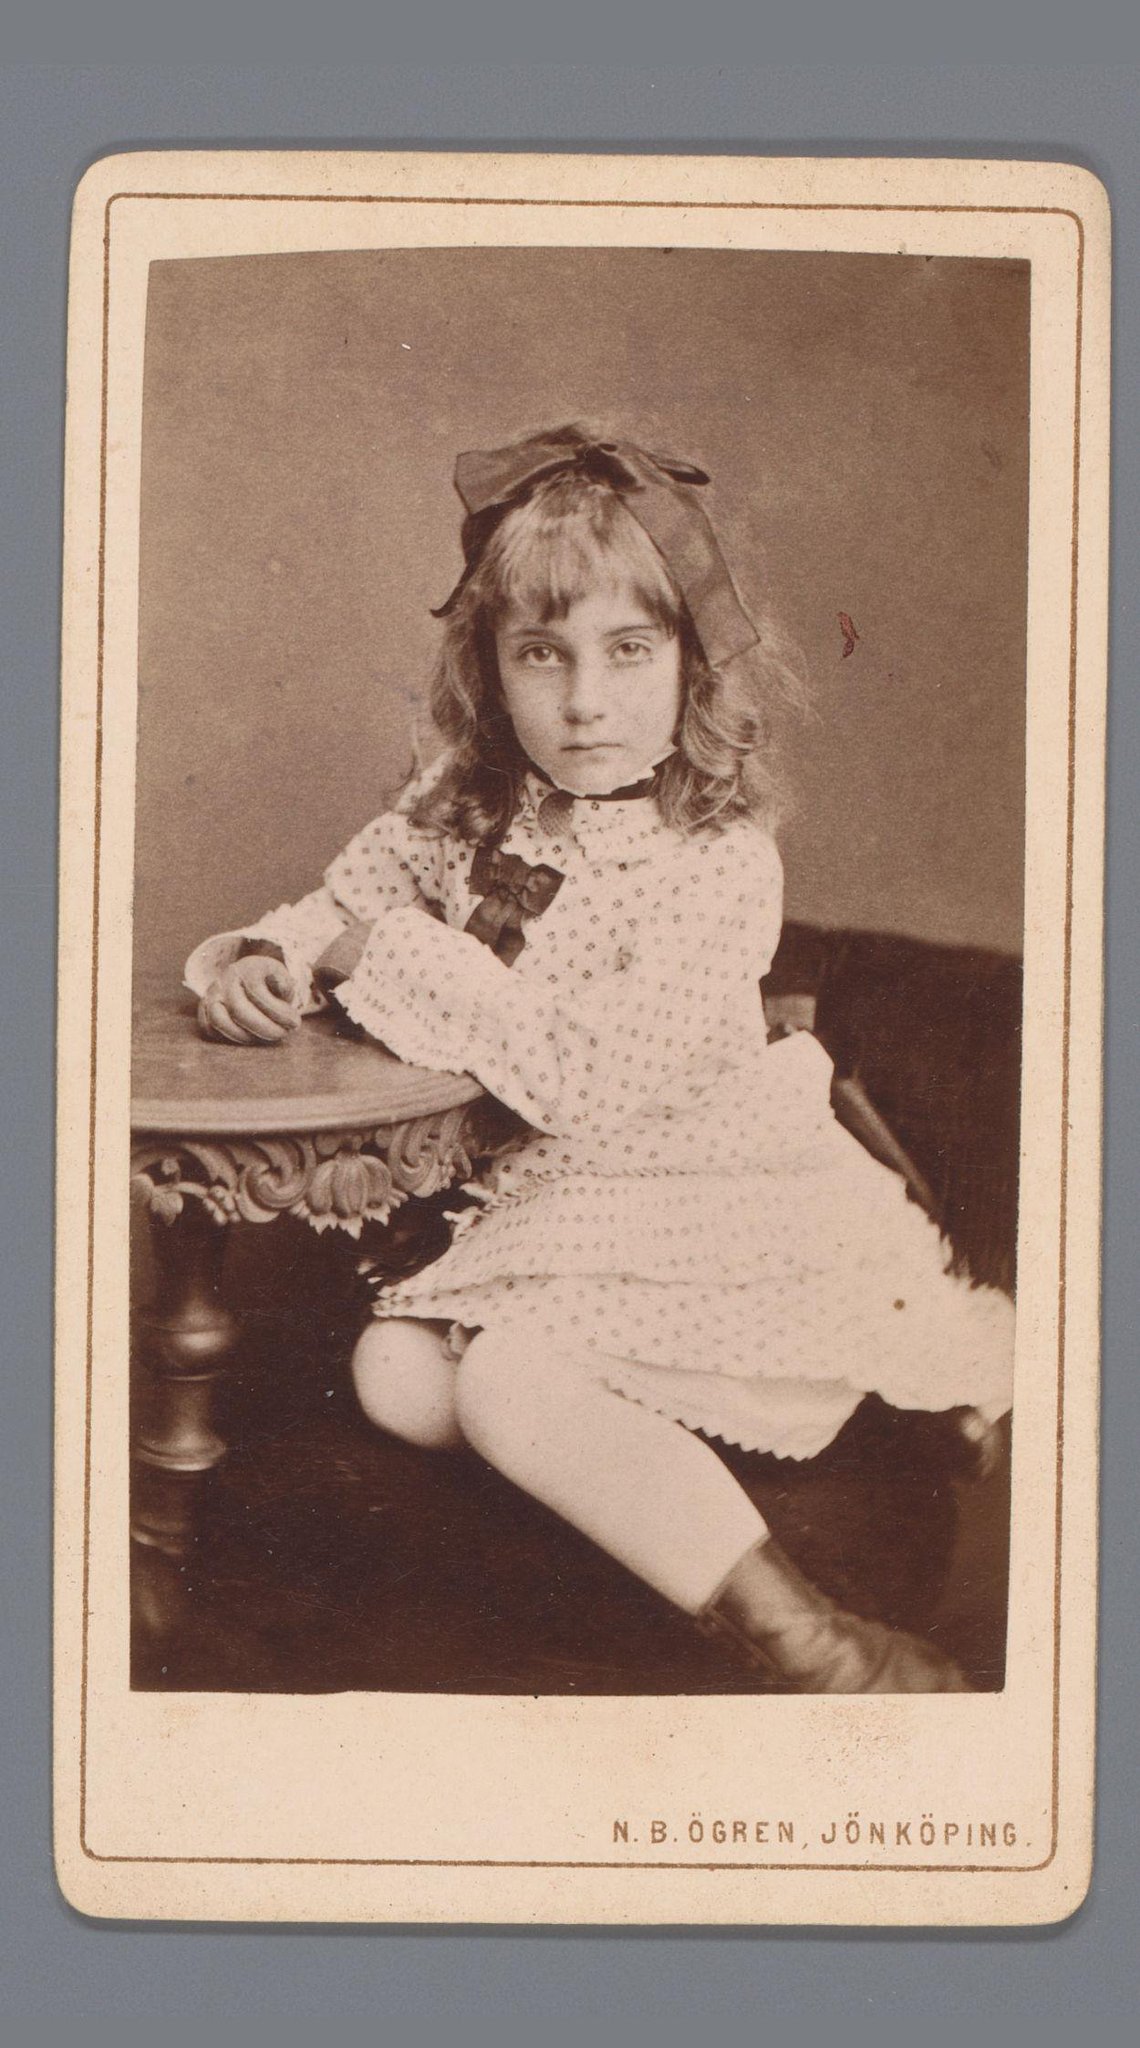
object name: carte de visite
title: Portret van een onbekend meisje, aangeduid als Lily, zittend aan tafel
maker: noach brynolf ögren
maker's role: fotograaf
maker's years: 1845-1877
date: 1876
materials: cardboard, paper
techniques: albumen print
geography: jönköping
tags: sitting figure, girl (child between toddler and youth), table, anonymous historical person portrayed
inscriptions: signature: ‘O. B. Ögren’, inscription: ‘JÖNKÖPING.’, inscription: ‘Lily Itån/ 18 oktb 1876’